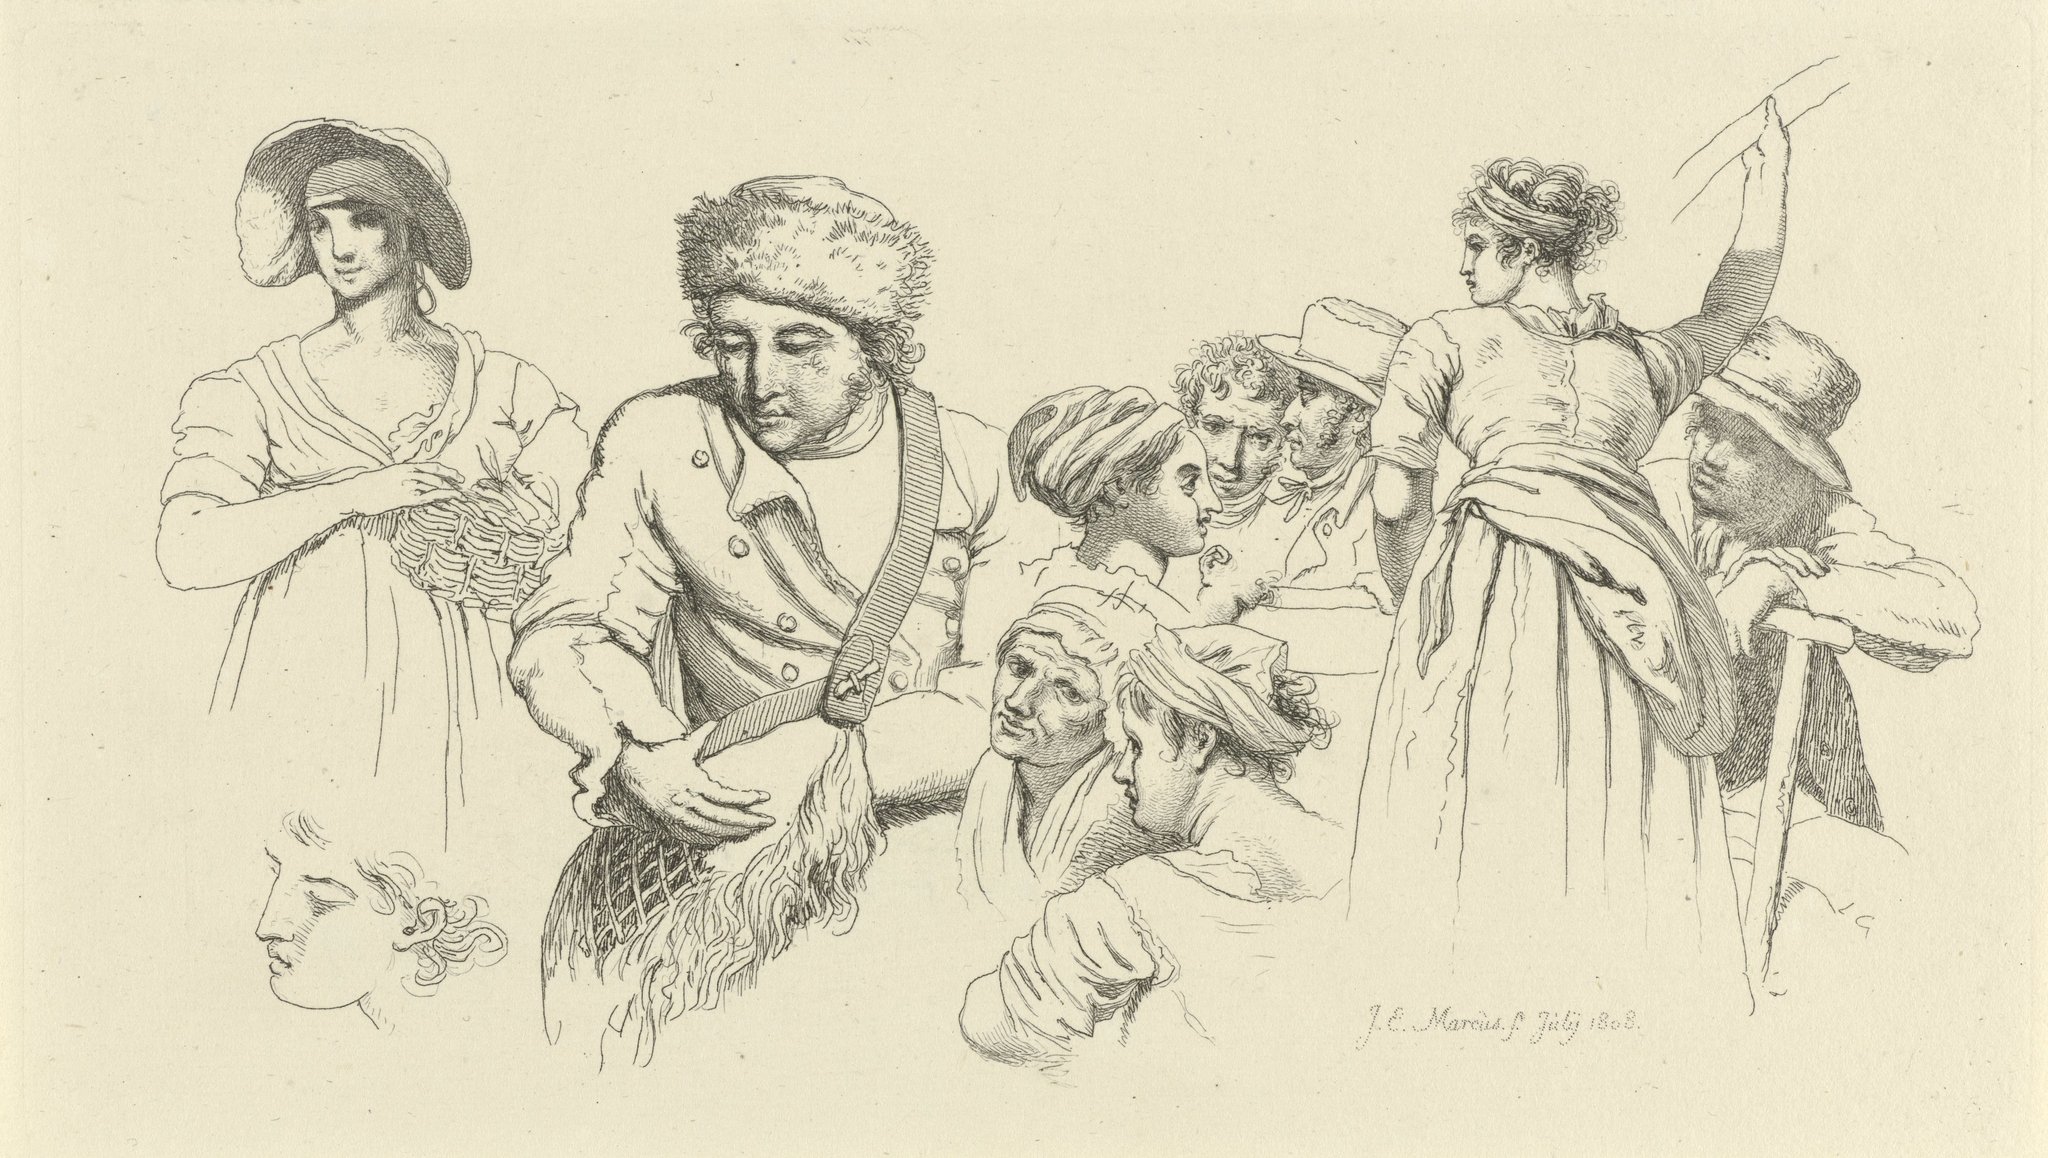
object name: print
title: Studie-prentwerk / Etudes gravées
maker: jacob ernst marcus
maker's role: draughtsman, print maker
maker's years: 1774-1826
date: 1807-1808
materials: paper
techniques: etching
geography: amsterdam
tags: adolescent, young woman, maiden, youth, adolescent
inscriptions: collector's mark: Lugt 2228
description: Serie voor het eerst uitgegeven door Jacob Ernst Marcus onder de titel Studiebeelden en Fragmenten. Amsterdam: ca.1816. Later heruitgegeven als: Studie-prentwerk/ Etudes gravées.